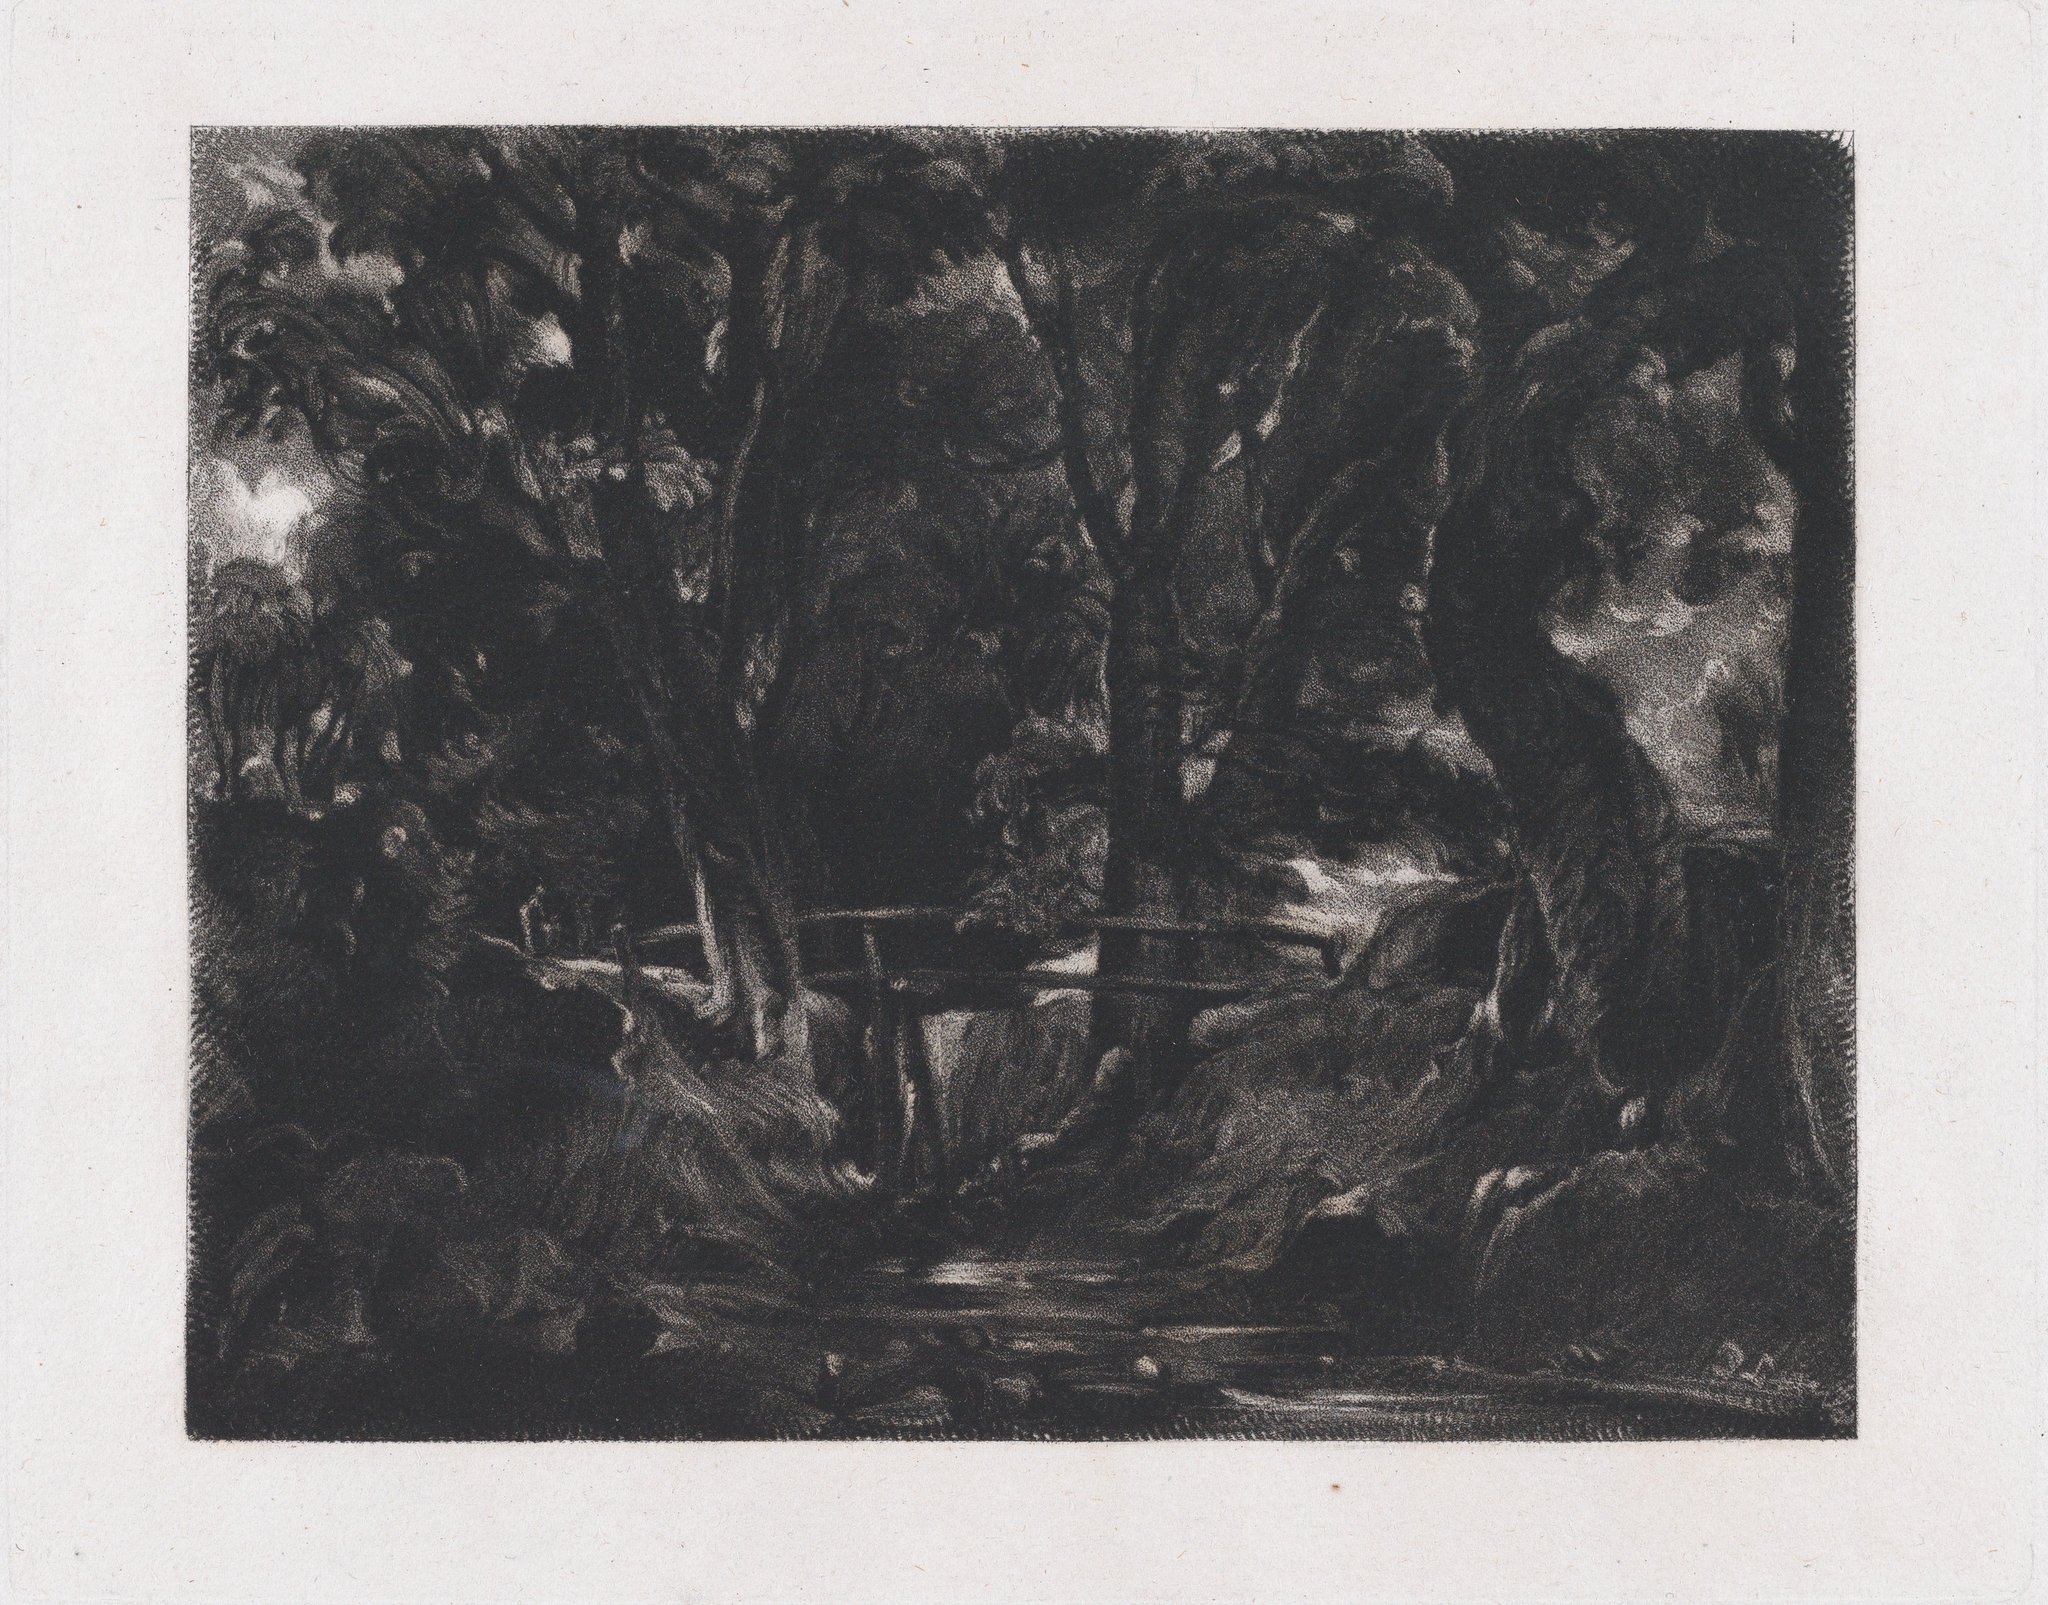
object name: print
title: A Dell, Helmingham Park, Suffolk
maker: david lucas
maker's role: artist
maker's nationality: british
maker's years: 1802-1881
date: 1830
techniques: mezzotint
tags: bridges,parks,trees